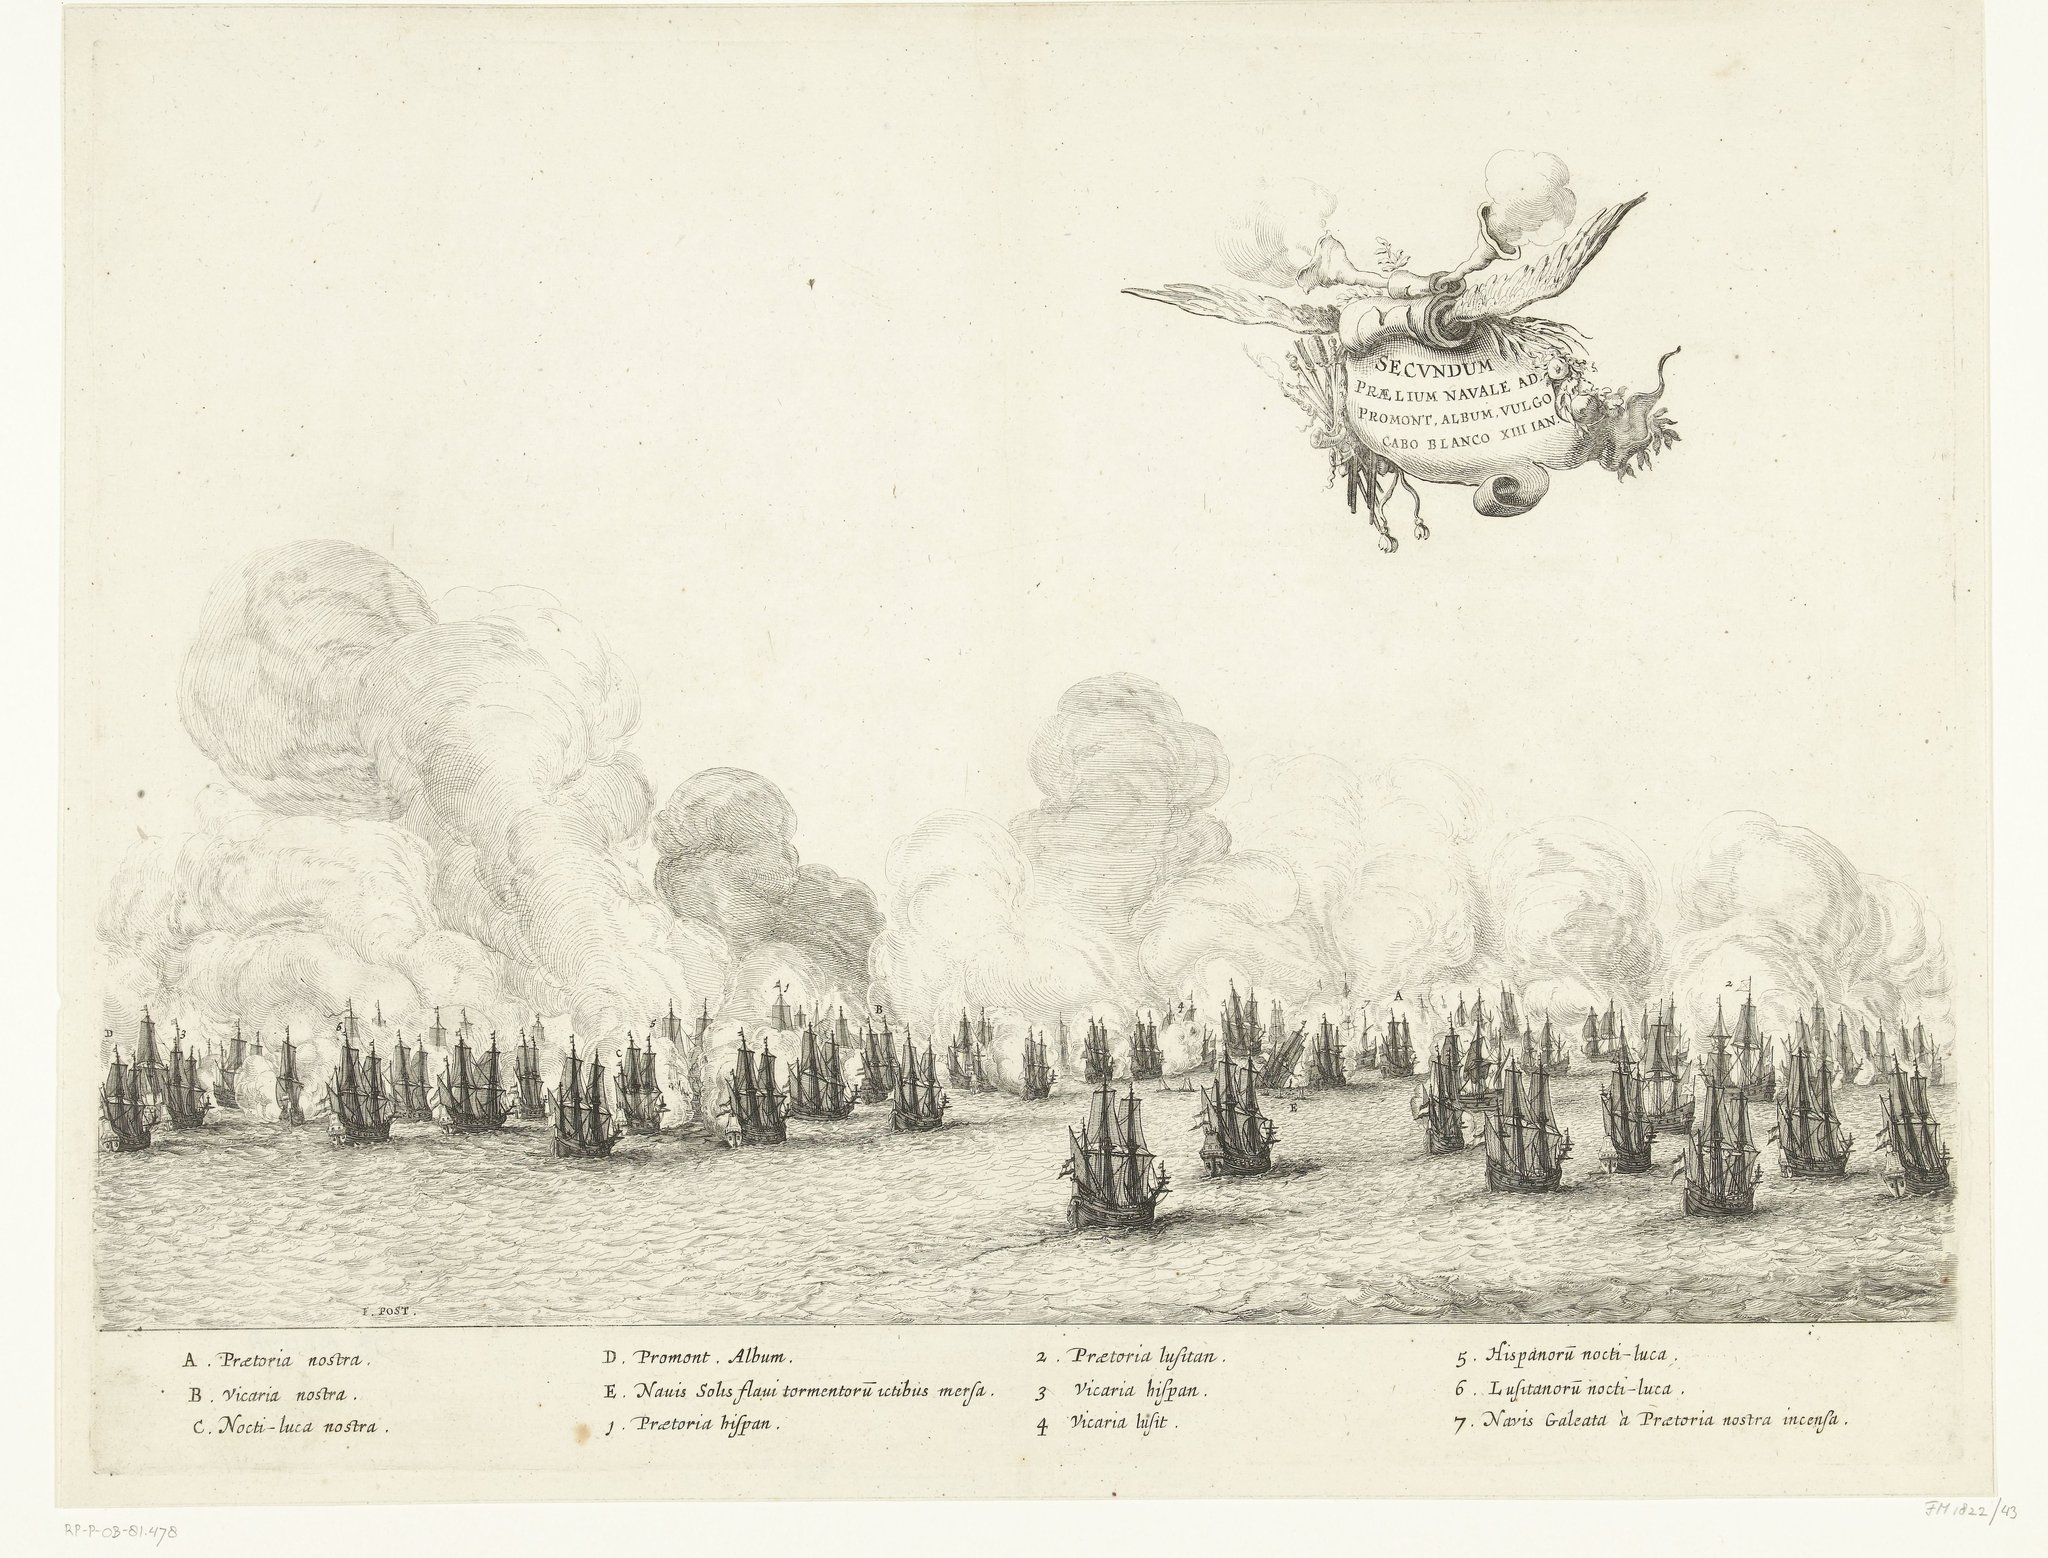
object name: print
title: Secundum praelium navale ad Promont, album, vulgo Cabo Blanco XIII Jan.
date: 1645-1647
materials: paper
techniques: etching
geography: northern netherlands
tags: earl, johan maurits graaf van nassau-siegen, battle (+ naval force)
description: Tweede gevecht tussen de vloot van de WIC onder Willem Cornelisz. Loos met de Portugese vloot onder graaf de la Torre bij Cabo Blanco (Branco), voor de kust bij Salvador (Bahia), 13 januari 1640. In de lucht een gevleugelde banderol met de titel en twee rookhoorns. In het onderschrift de verklaring van de letters A-E en de cijfers 1-7 in het Latijn. Plaat [nr. 43] in een serie van 55 voorstellingen van de tocht naar en het verblijf in Brazilië van graaf Johan Maurits van Nassau in de jaren 1636-1644.